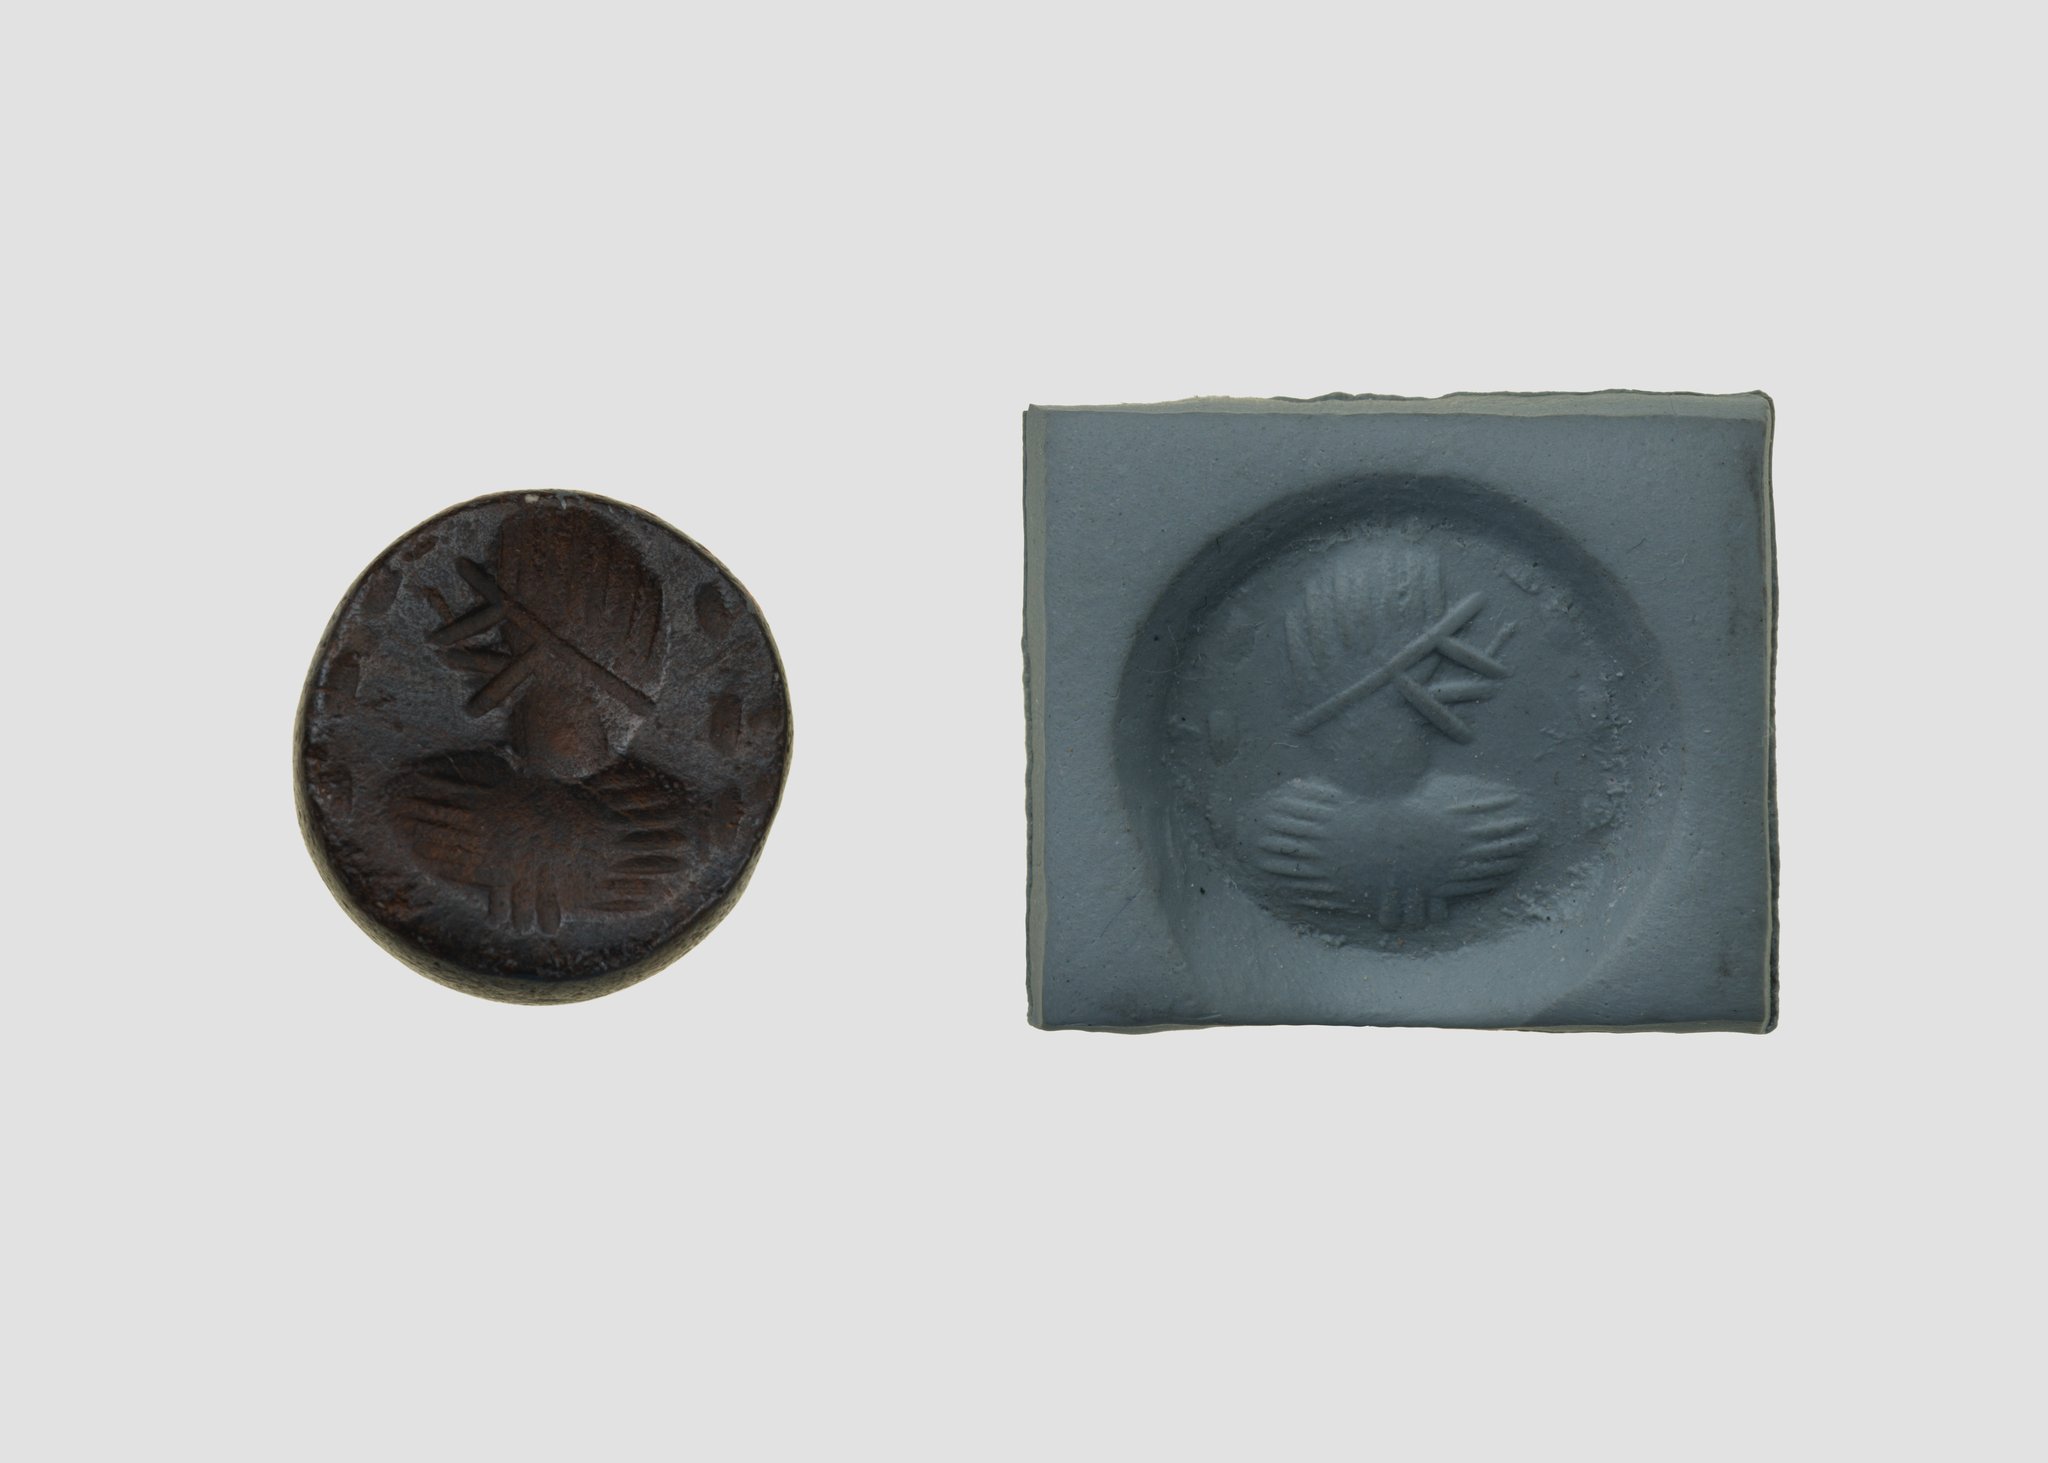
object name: stamp seal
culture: sasanian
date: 401-500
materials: mineral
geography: iran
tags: men